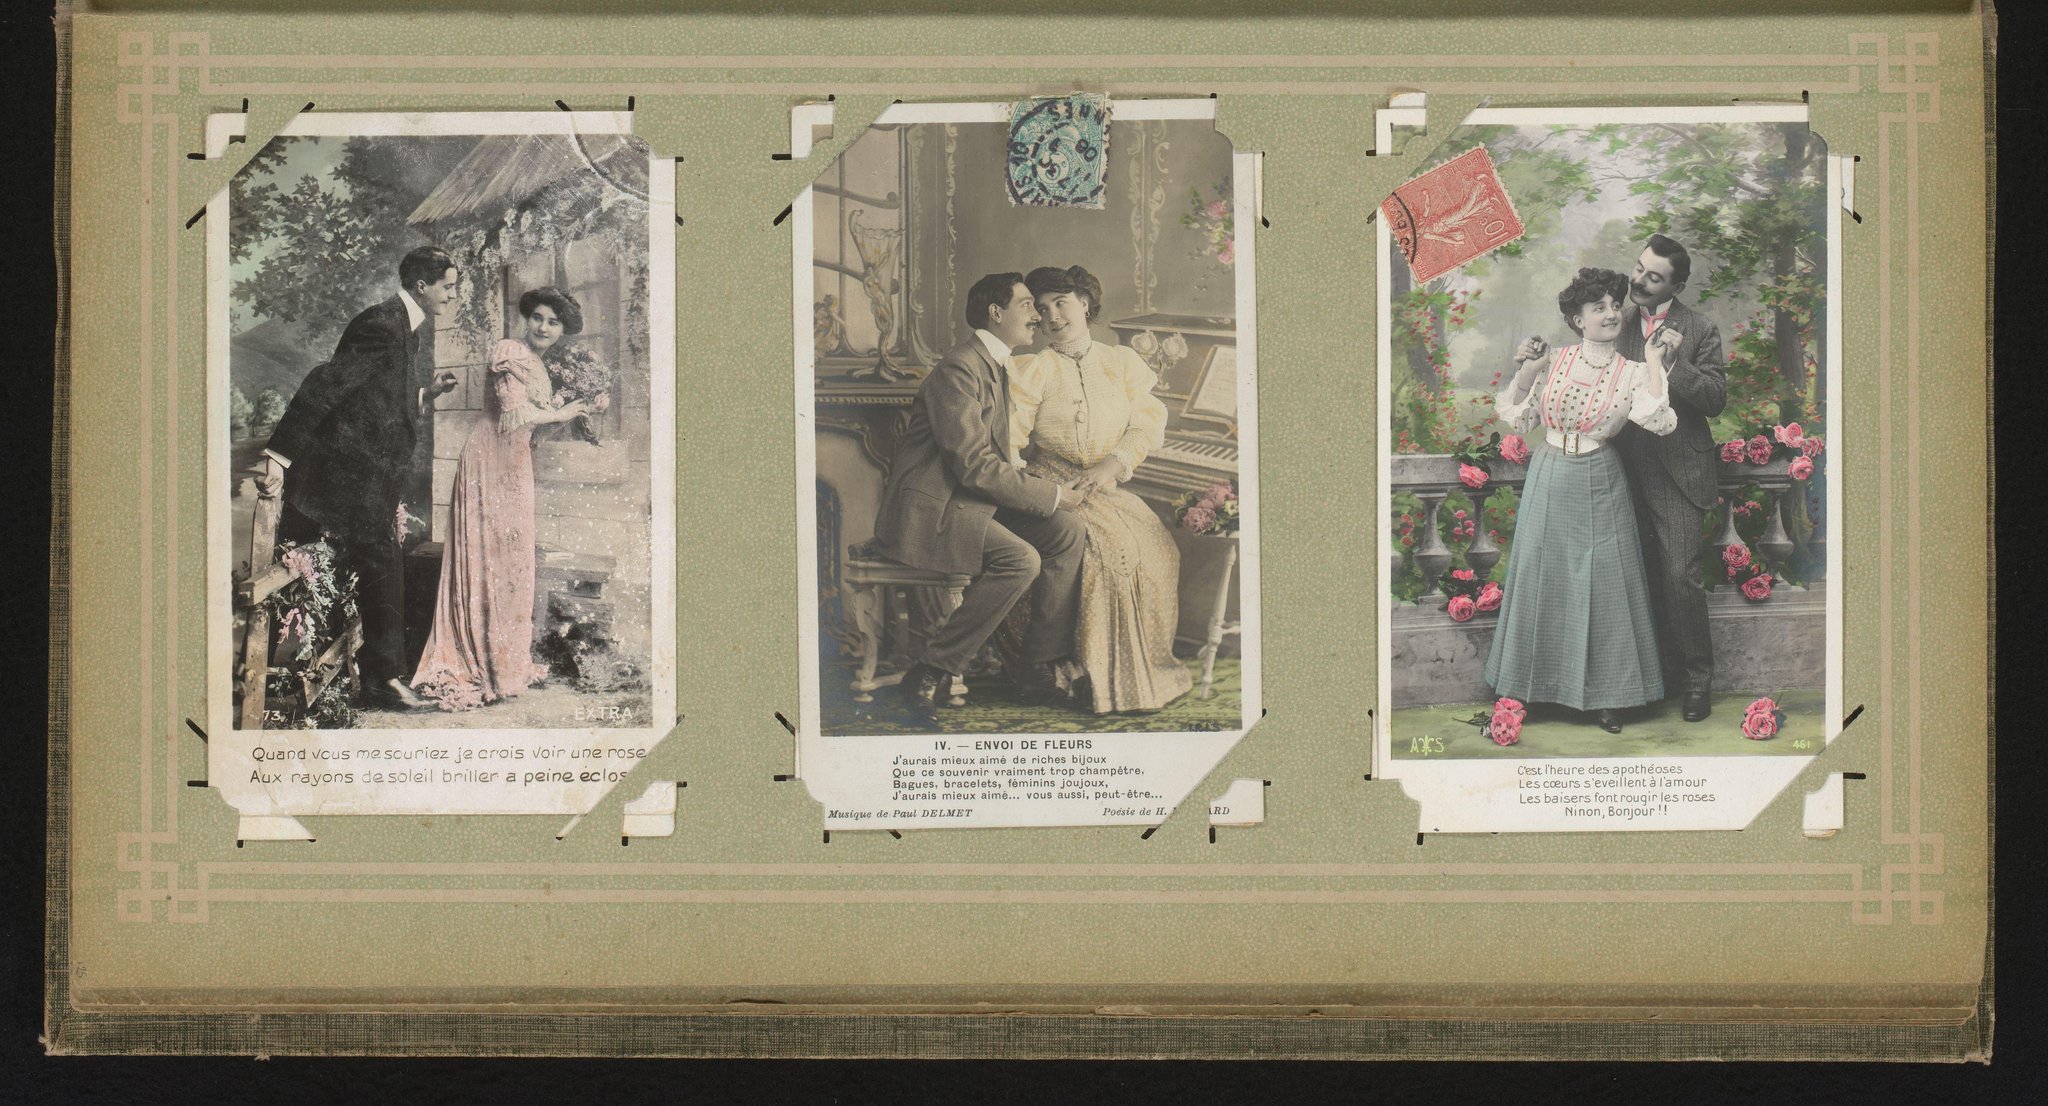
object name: photograph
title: Drie portretten van een paar geliefden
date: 1900-1930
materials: cardboard, photographic support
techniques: gelatin silver print, hand coloring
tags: historical persons - bb - woman, historical persons, couple of lovers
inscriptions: monogram: ‘A S’, monogram: ‘EXTRA’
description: Deze foto's maken deel uit van een album.